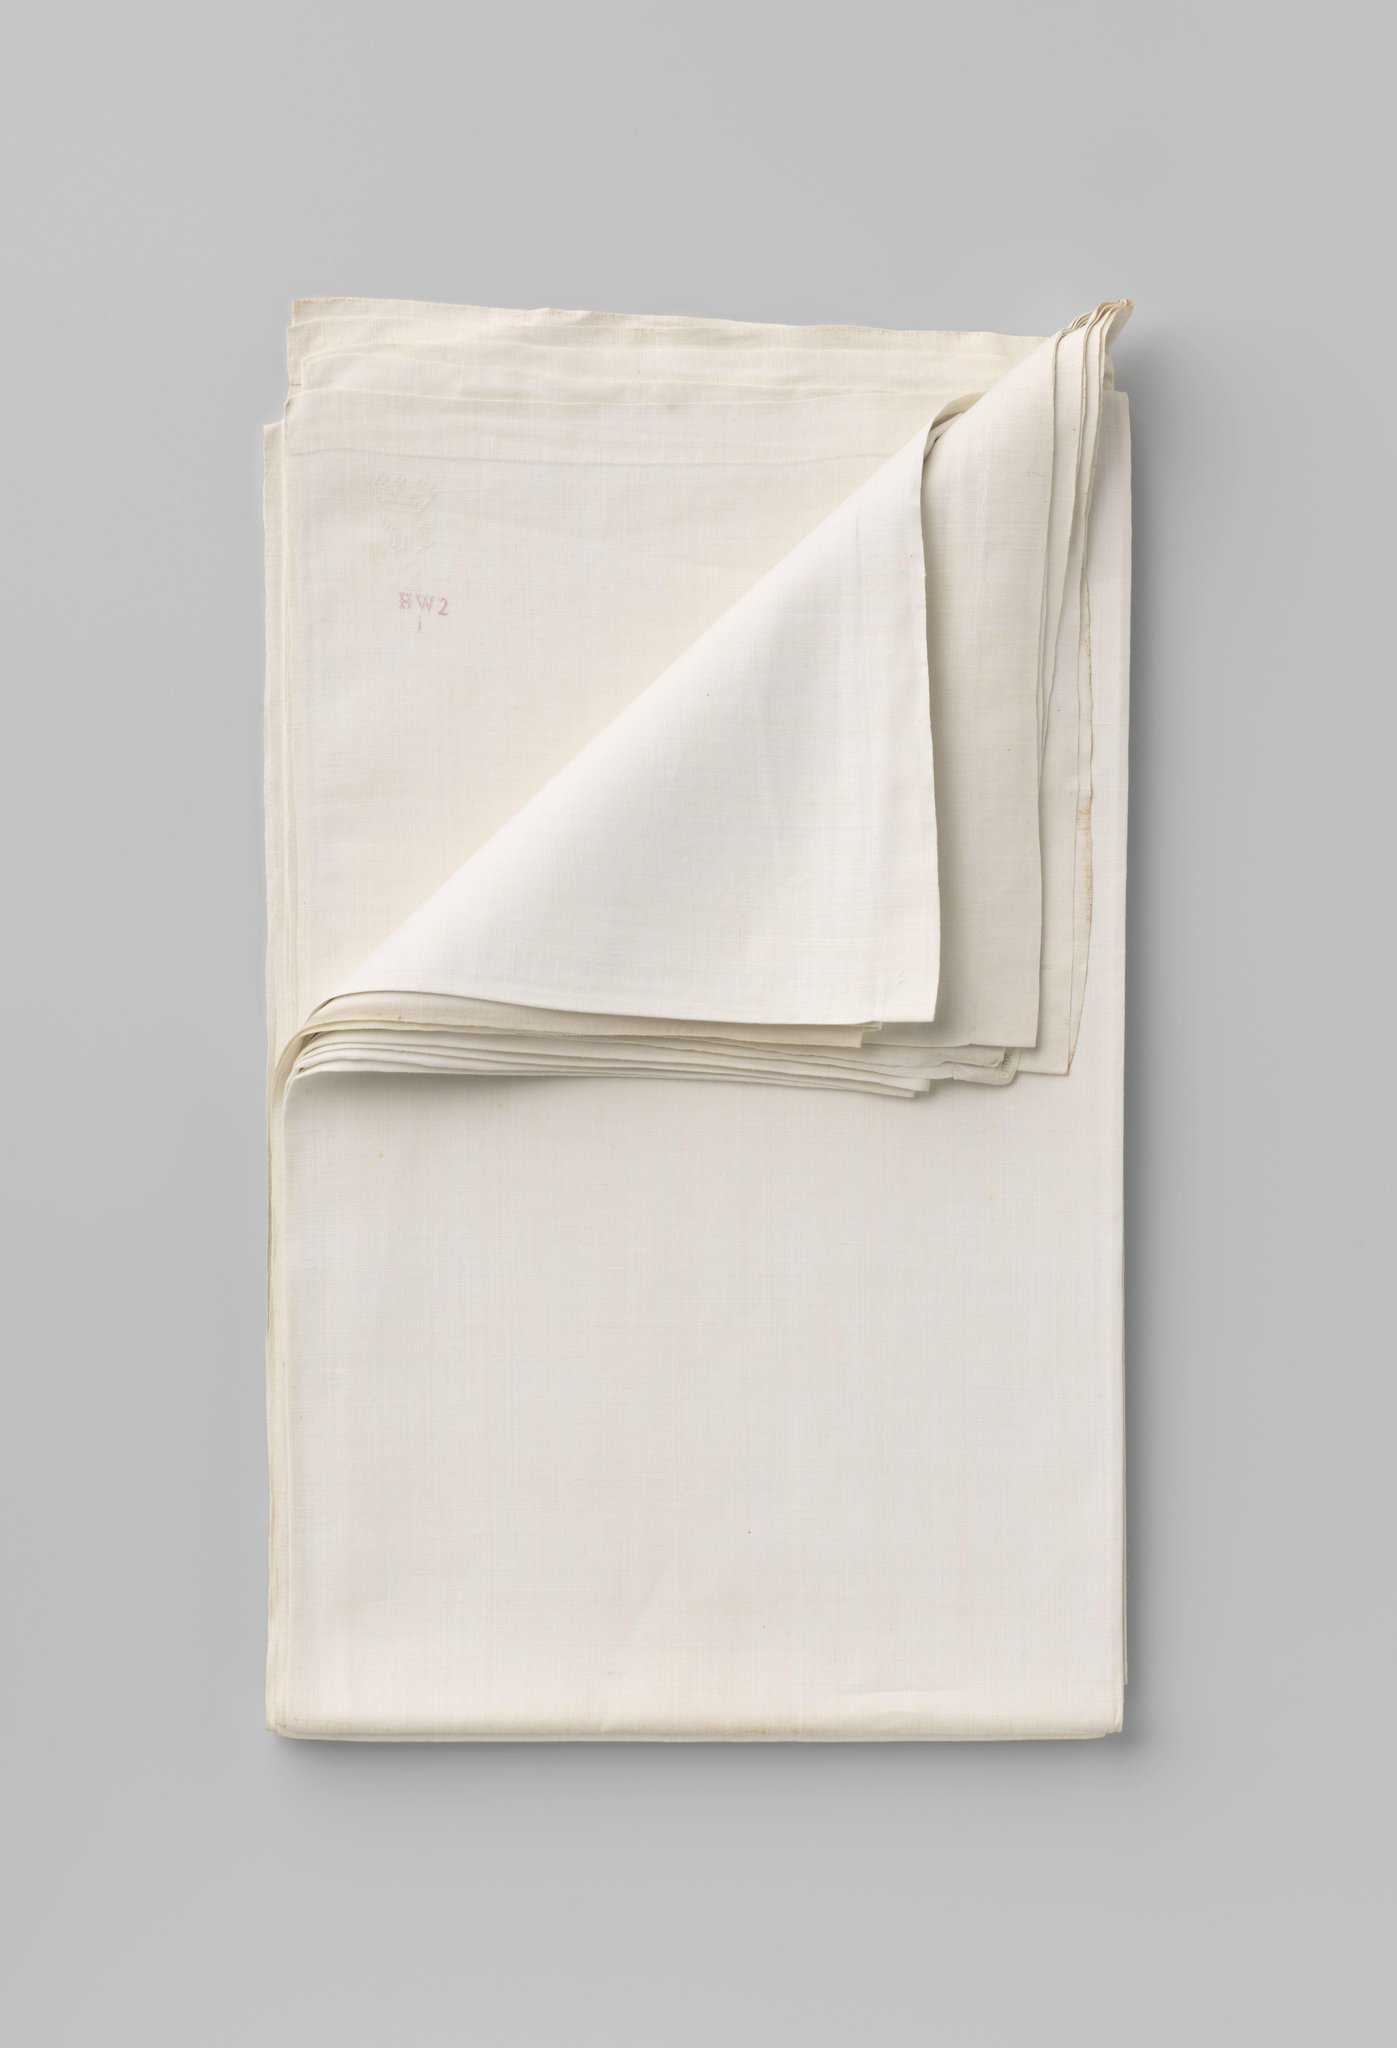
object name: beddenlaken, laken object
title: Laken. Merk: kroon WG2 en HW12.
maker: Anonymous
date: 1723-1769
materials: linen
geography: northern netherlands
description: Laken van wit linnen, merk kroon WG 2 HW1 2